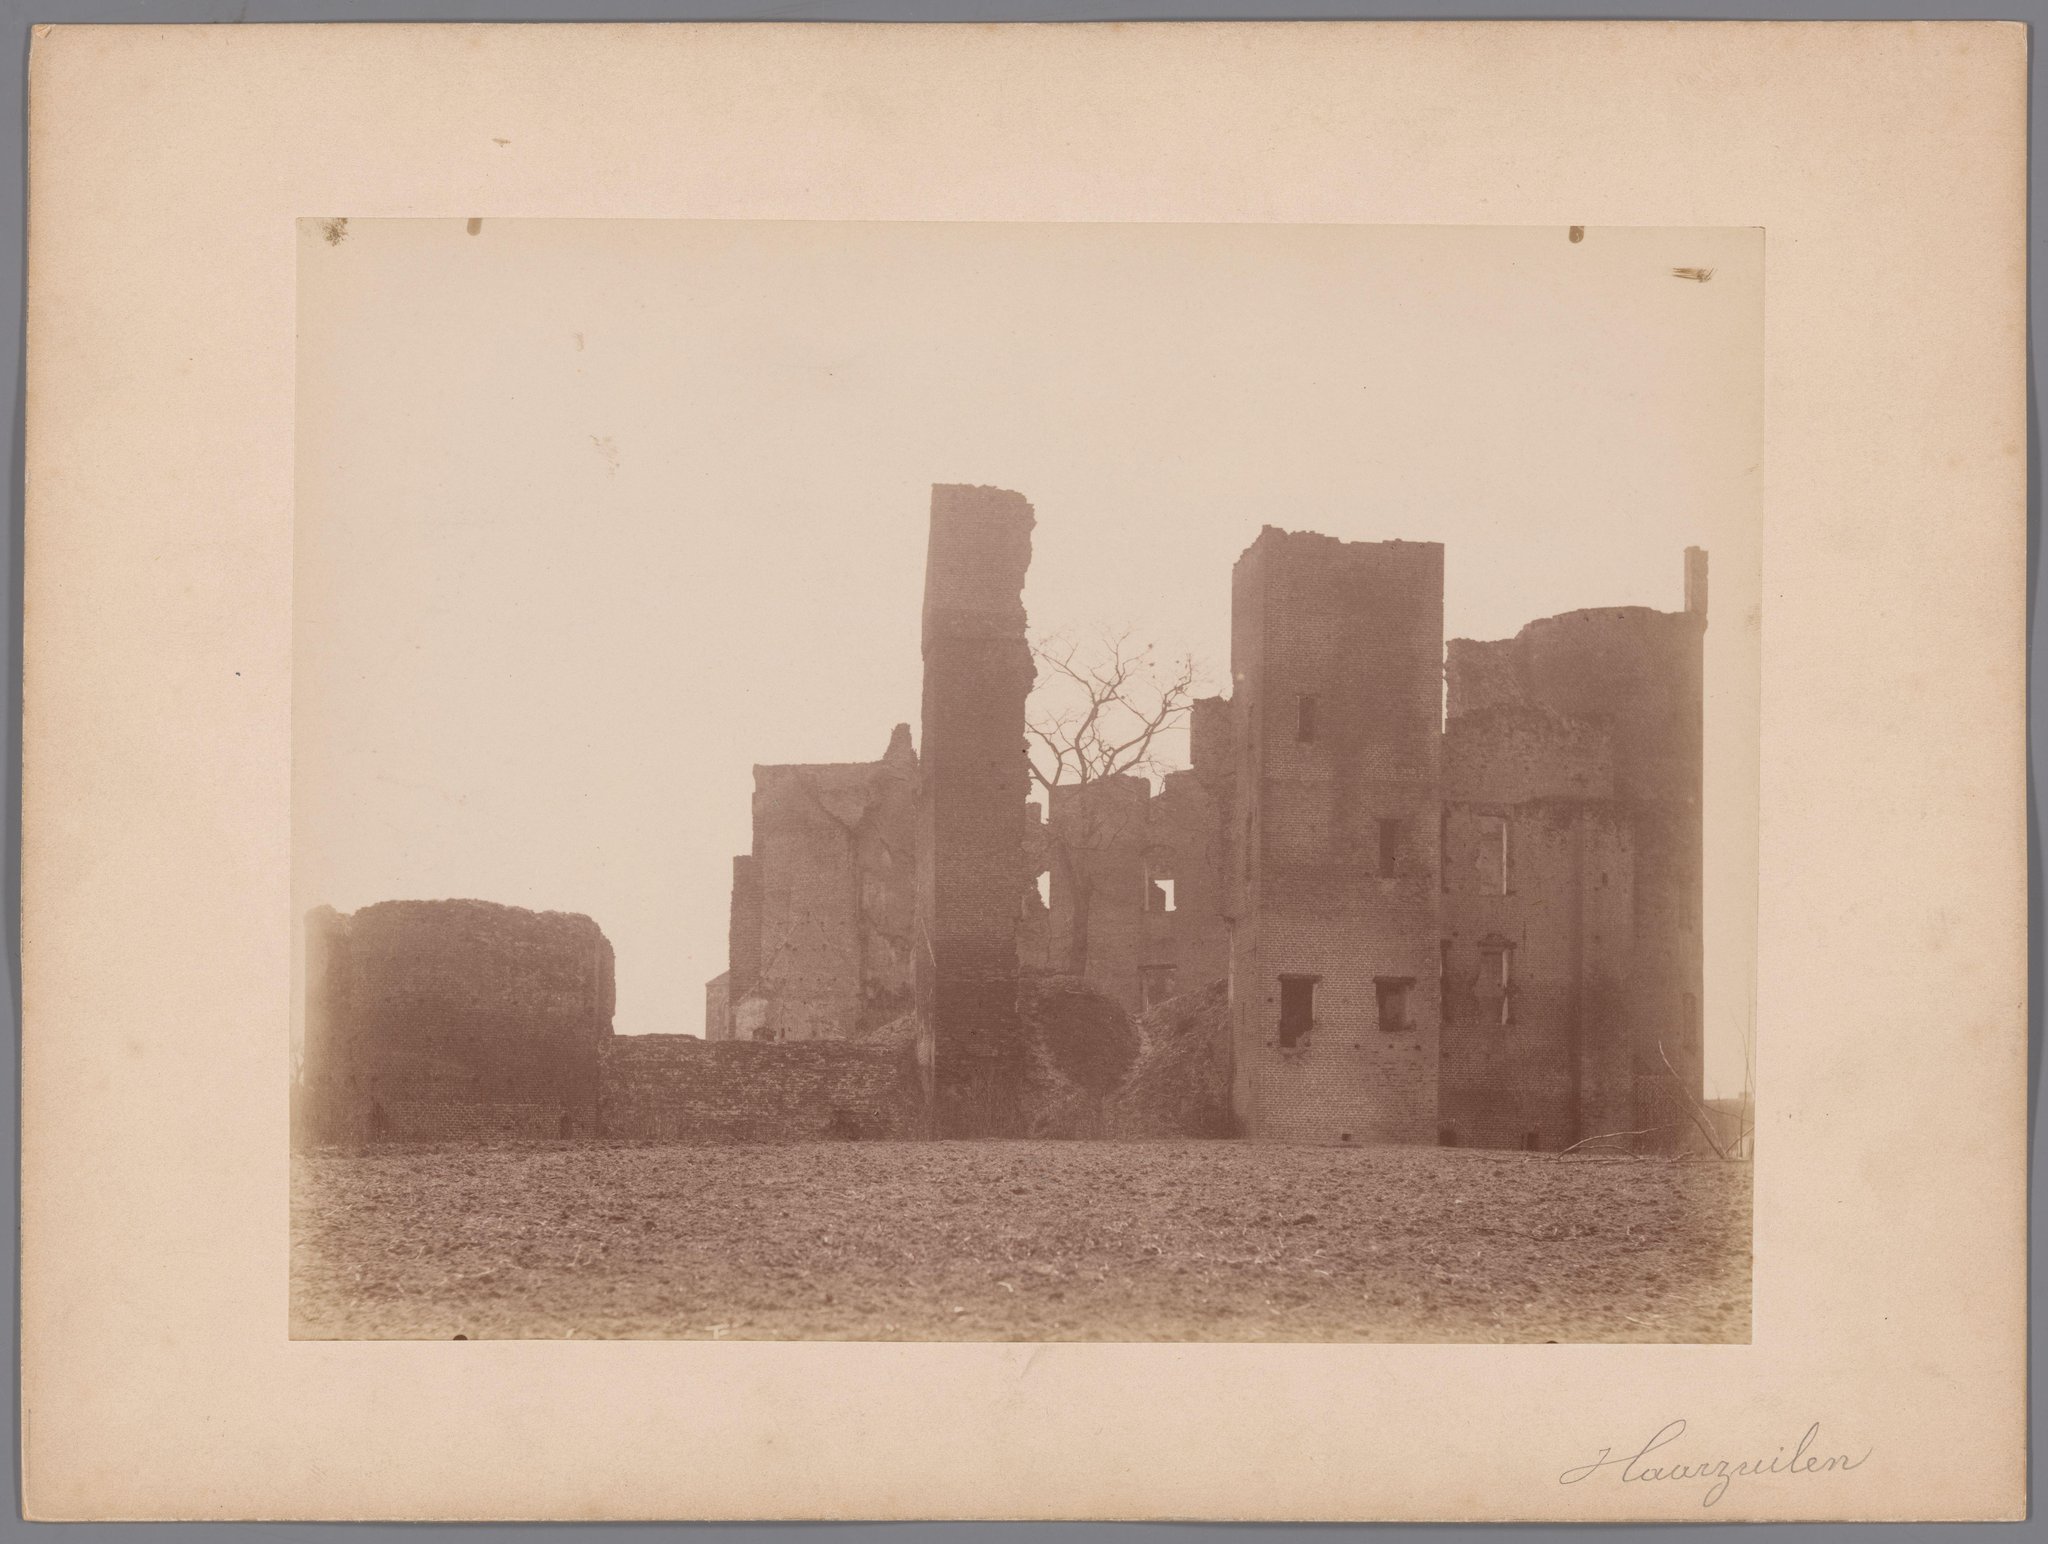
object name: photograph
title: Ruïne van Kasteel de Haar te Haarzuilens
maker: anoniem (monumentenzorg)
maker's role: fotograaf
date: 1885-1892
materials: cardboard, photographic support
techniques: albumen print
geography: haarzuilens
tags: landscape with ruins, ruin of a dwelling, house, castle, etc.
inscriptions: annotation: ‘Huis de Haar/ Ruine’, annotation: ‘Haarzuilen’